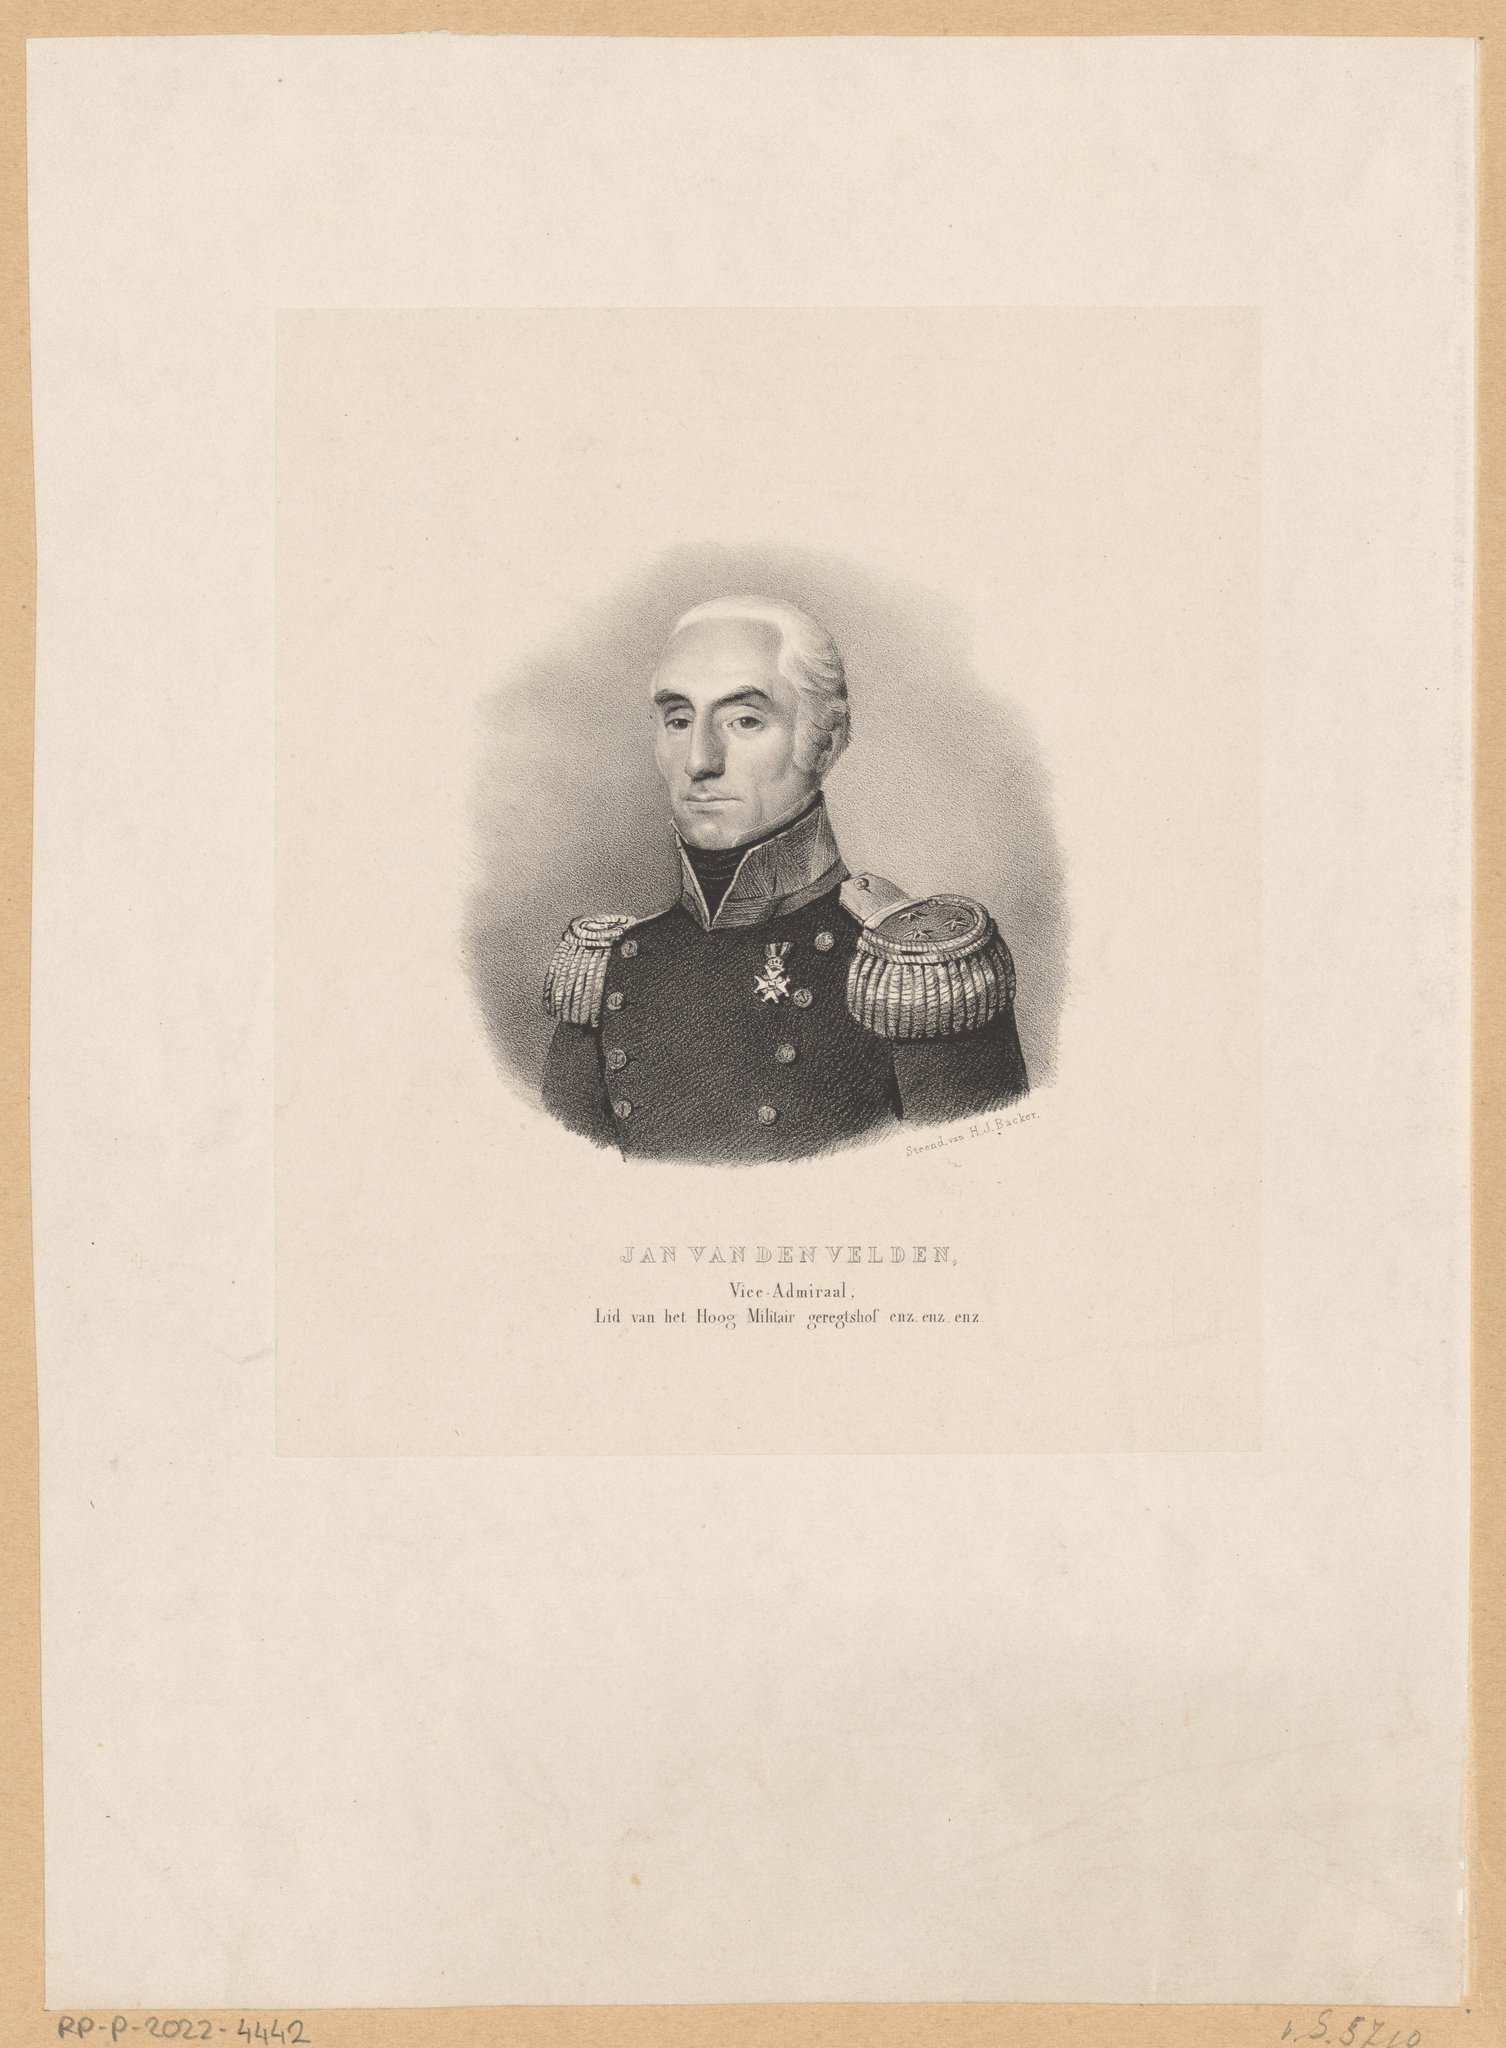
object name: print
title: Portret van Jan van den Velden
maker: Anonymous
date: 1822-1845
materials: paper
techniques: lithograph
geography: netherlands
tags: amsterdam, utrecht, knighthood order, historical persons, commander-in-chief, admiral